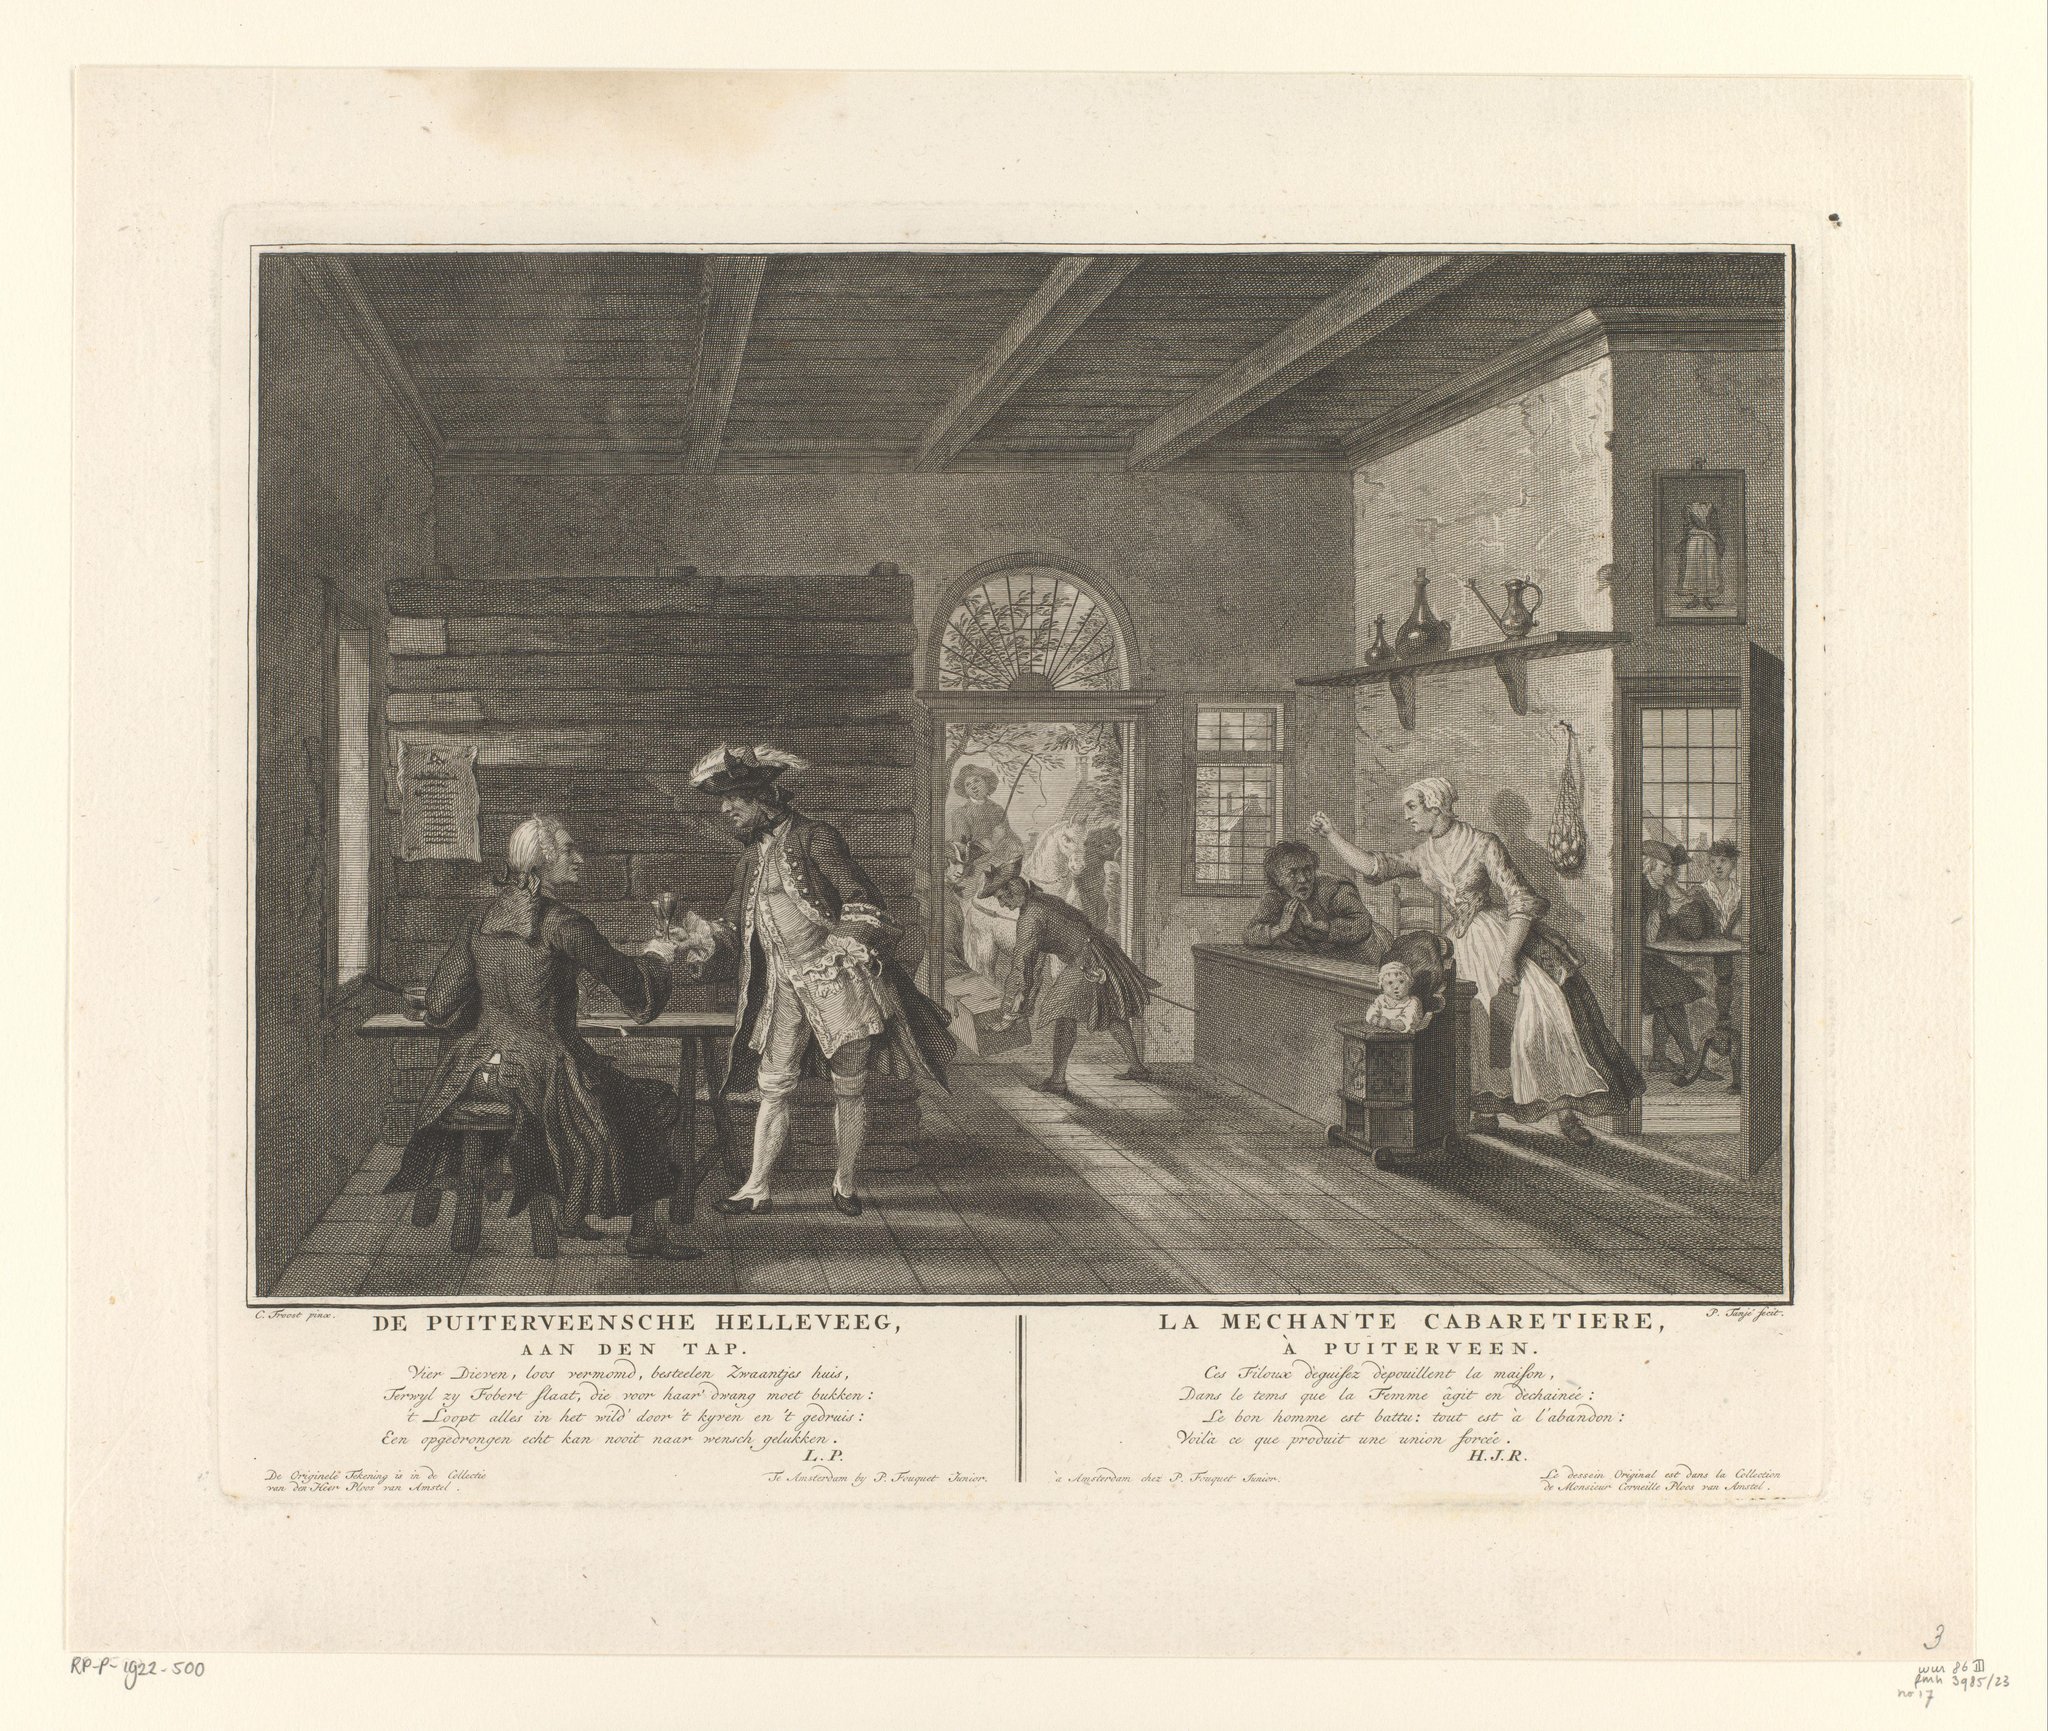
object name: print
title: De Puiterveensche helleveeg, aan den tap / La Mechante cabaretiere, à Puiterveen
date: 1752-1761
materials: paper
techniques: engraving, etching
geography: amsterdam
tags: inn, coffee-house, public house, etc., drinking, satire on marriage, comedy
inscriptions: collector's mark: Lugt 2228, collector's mark: Lugt 2233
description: De verklede dieven Jan de Rolder en Piet Pothuis heffen het glas in de gelagkamer, waar Swaantje achter de tapkast tegen haar man Fobert staat te tieren. Ze is daar zo druk mee, dat ze niet door heeft dat ze wordt bestolen. In de zijkamer rechts zitten Hartje Spilpenning en Saartje van Lichten gekleed als doopsgezinden. Onderaan in de marge een vierregelig vers in het Nederlands en het Frans. Scène uit het tweede bedrijf van het toneelstuk De Puiterveense helleveeg, of Beslikte Swaantje aan den tap, van Abraham Alewijn.